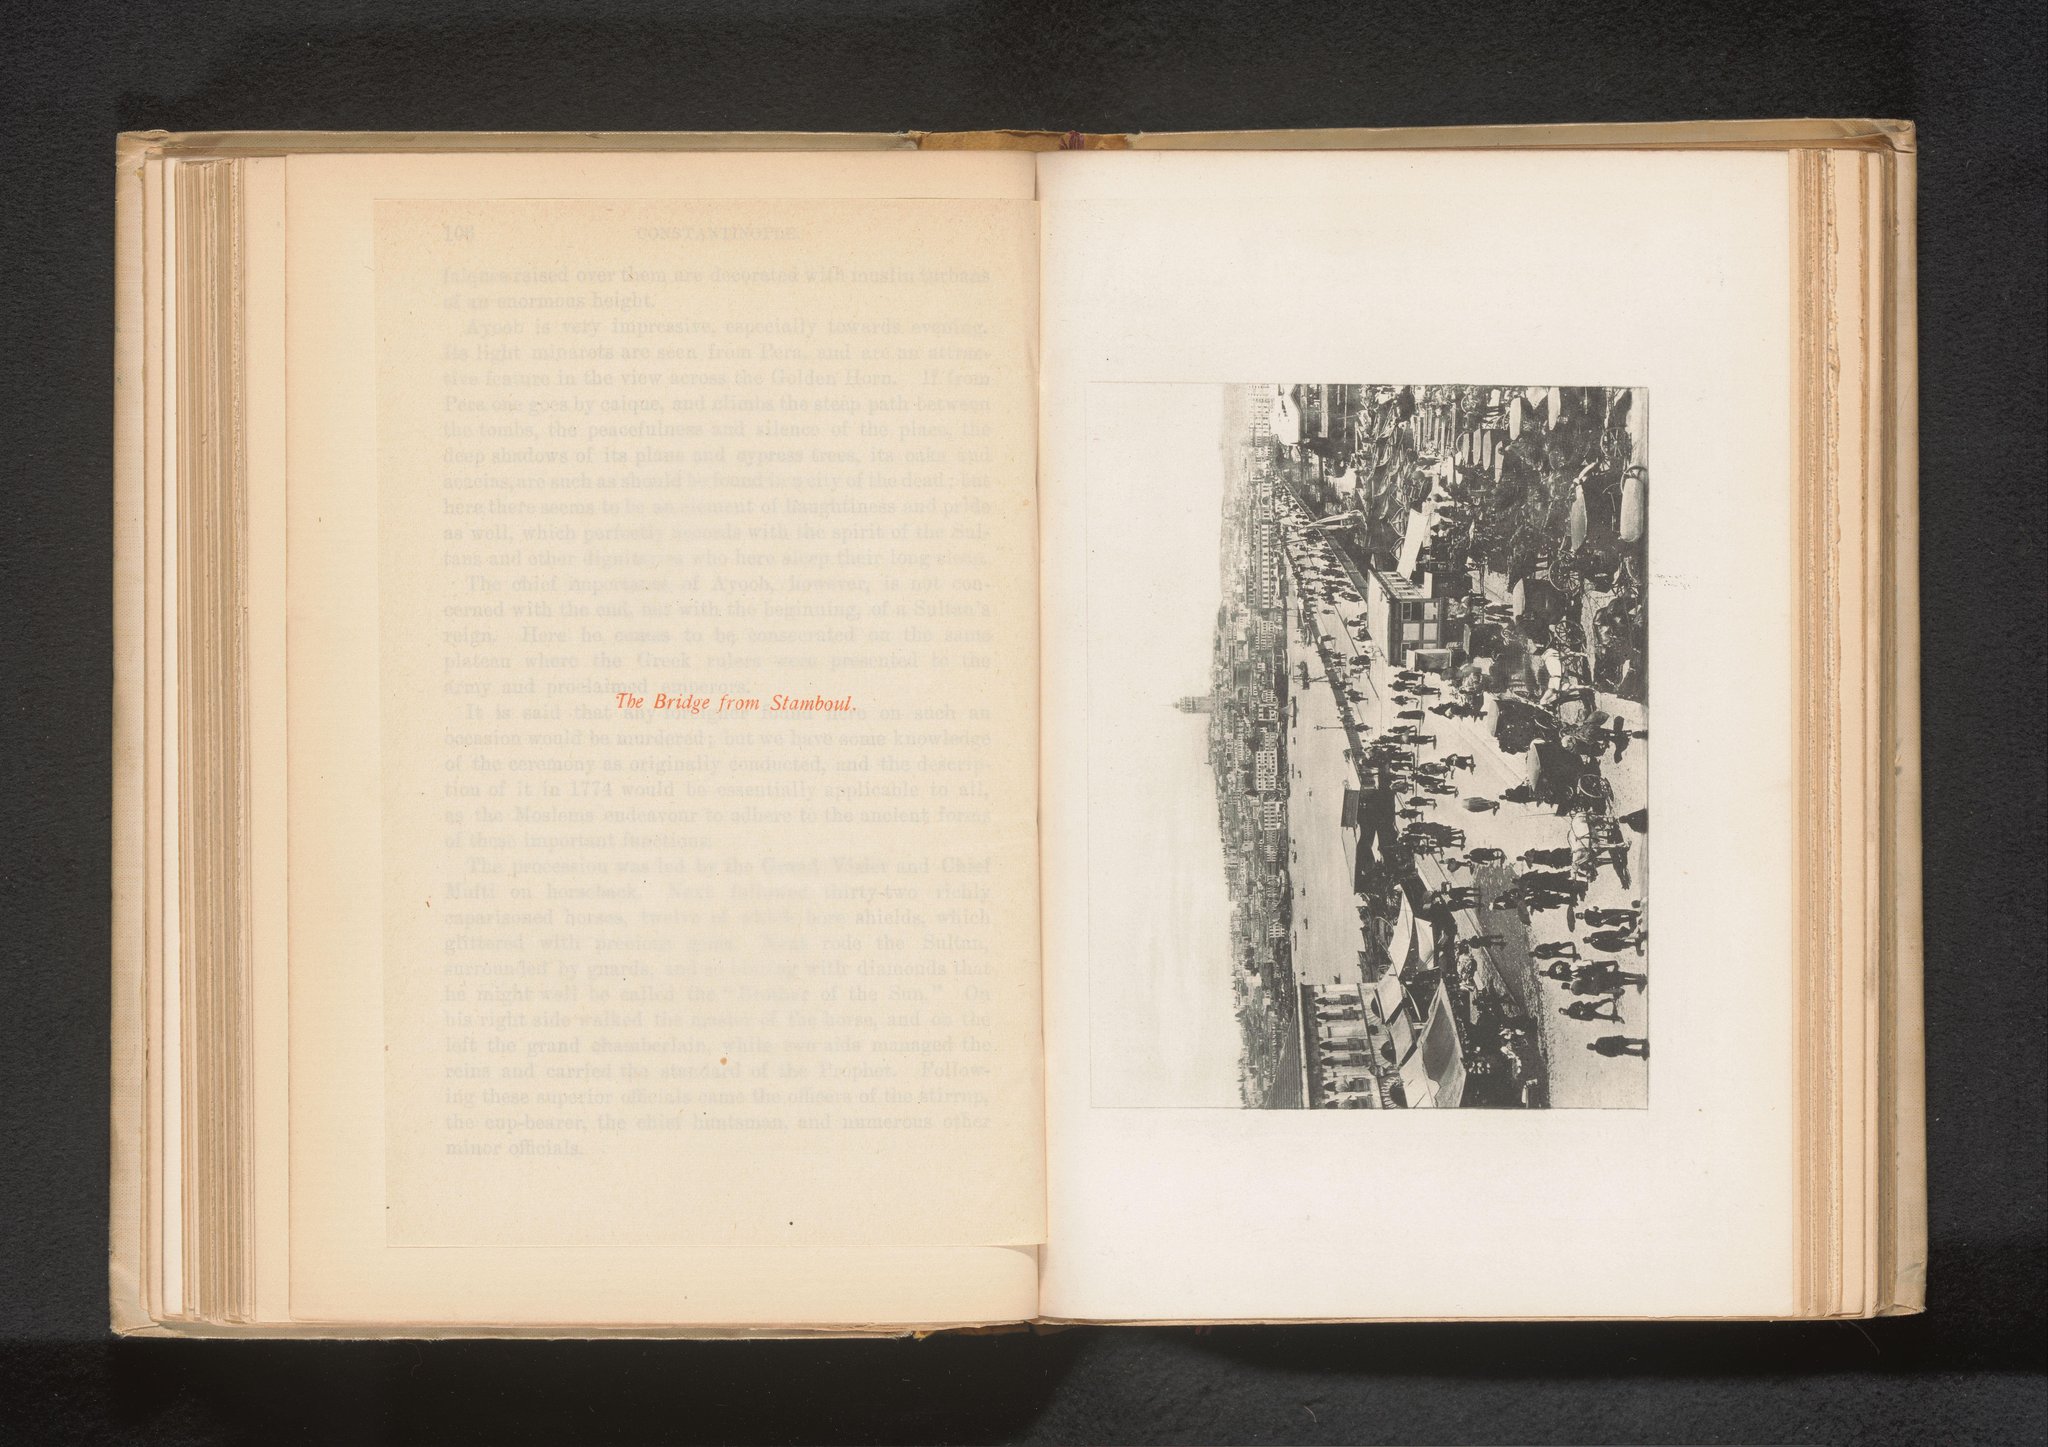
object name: photomechanical print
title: Gezicht op de Galatabrug te Constantinopel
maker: Anonymous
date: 1885-1895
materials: paper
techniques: photoaquatint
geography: constantinople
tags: bascule bridge, river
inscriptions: title: ‘The Bridge from Stamboul.’